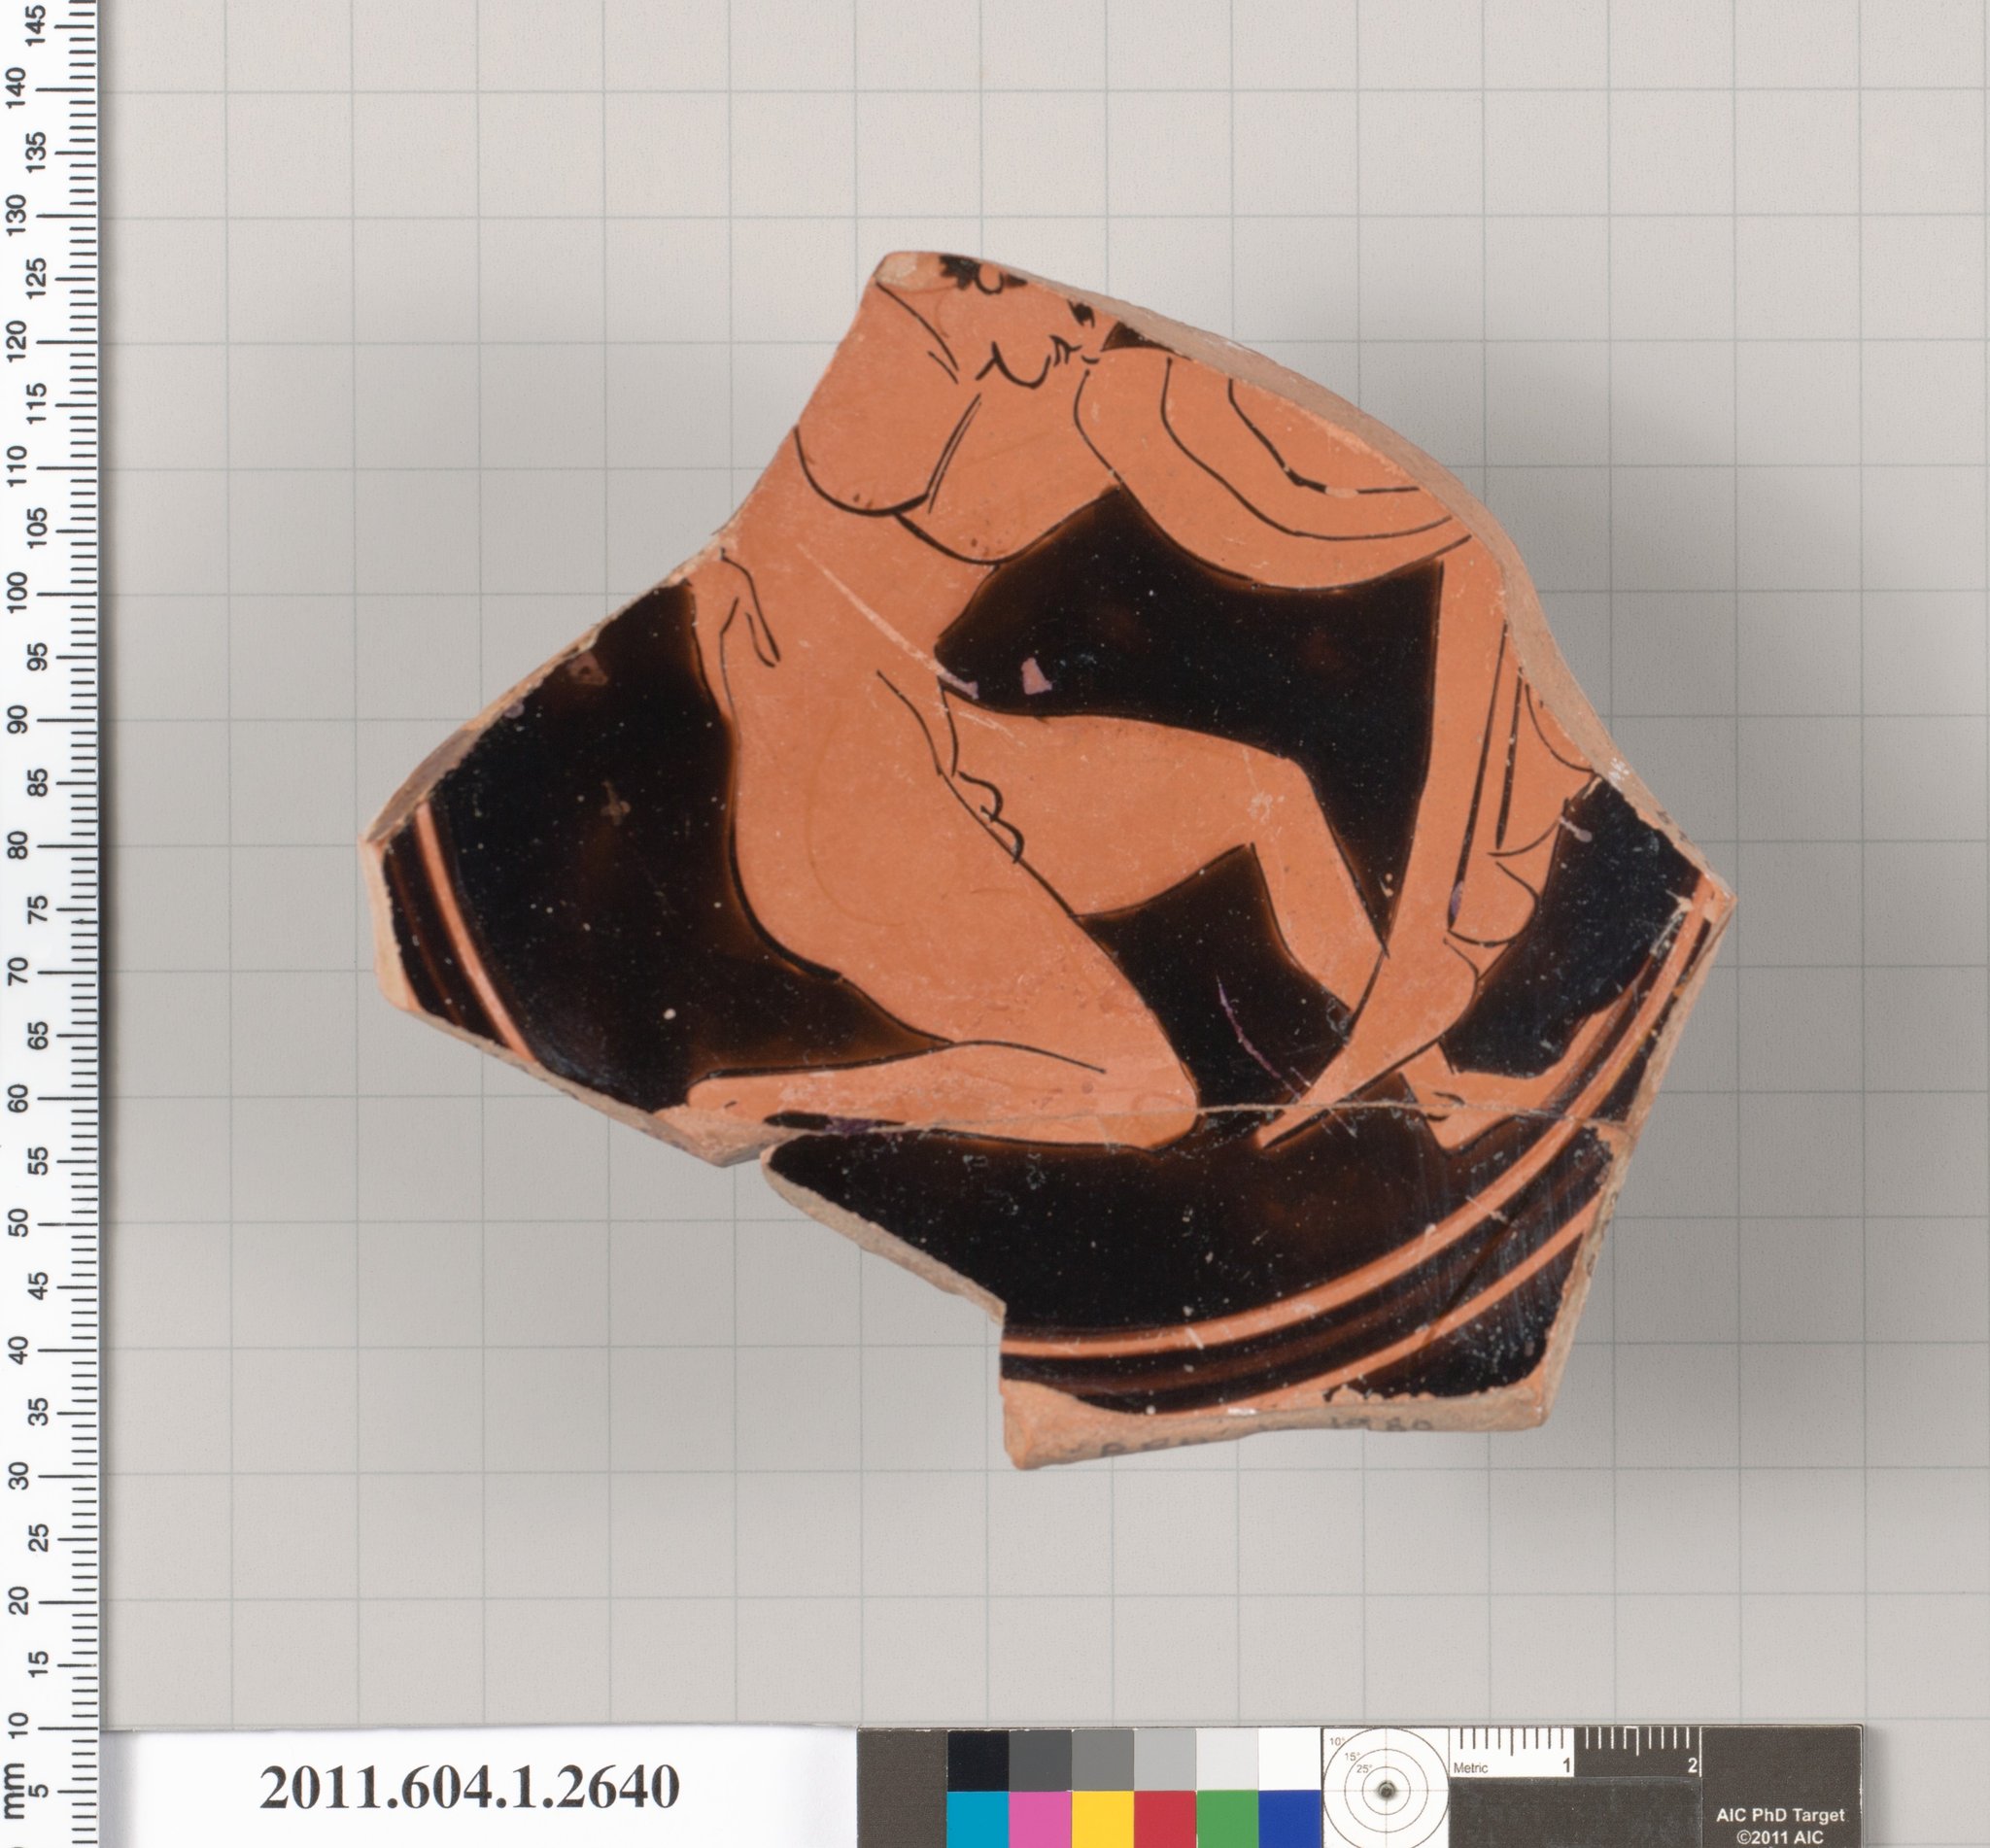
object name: kylix fragment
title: Terracotta fragment of a kylix (drinking cup)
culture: greek, attic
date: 520-510 BCE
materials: terracotta